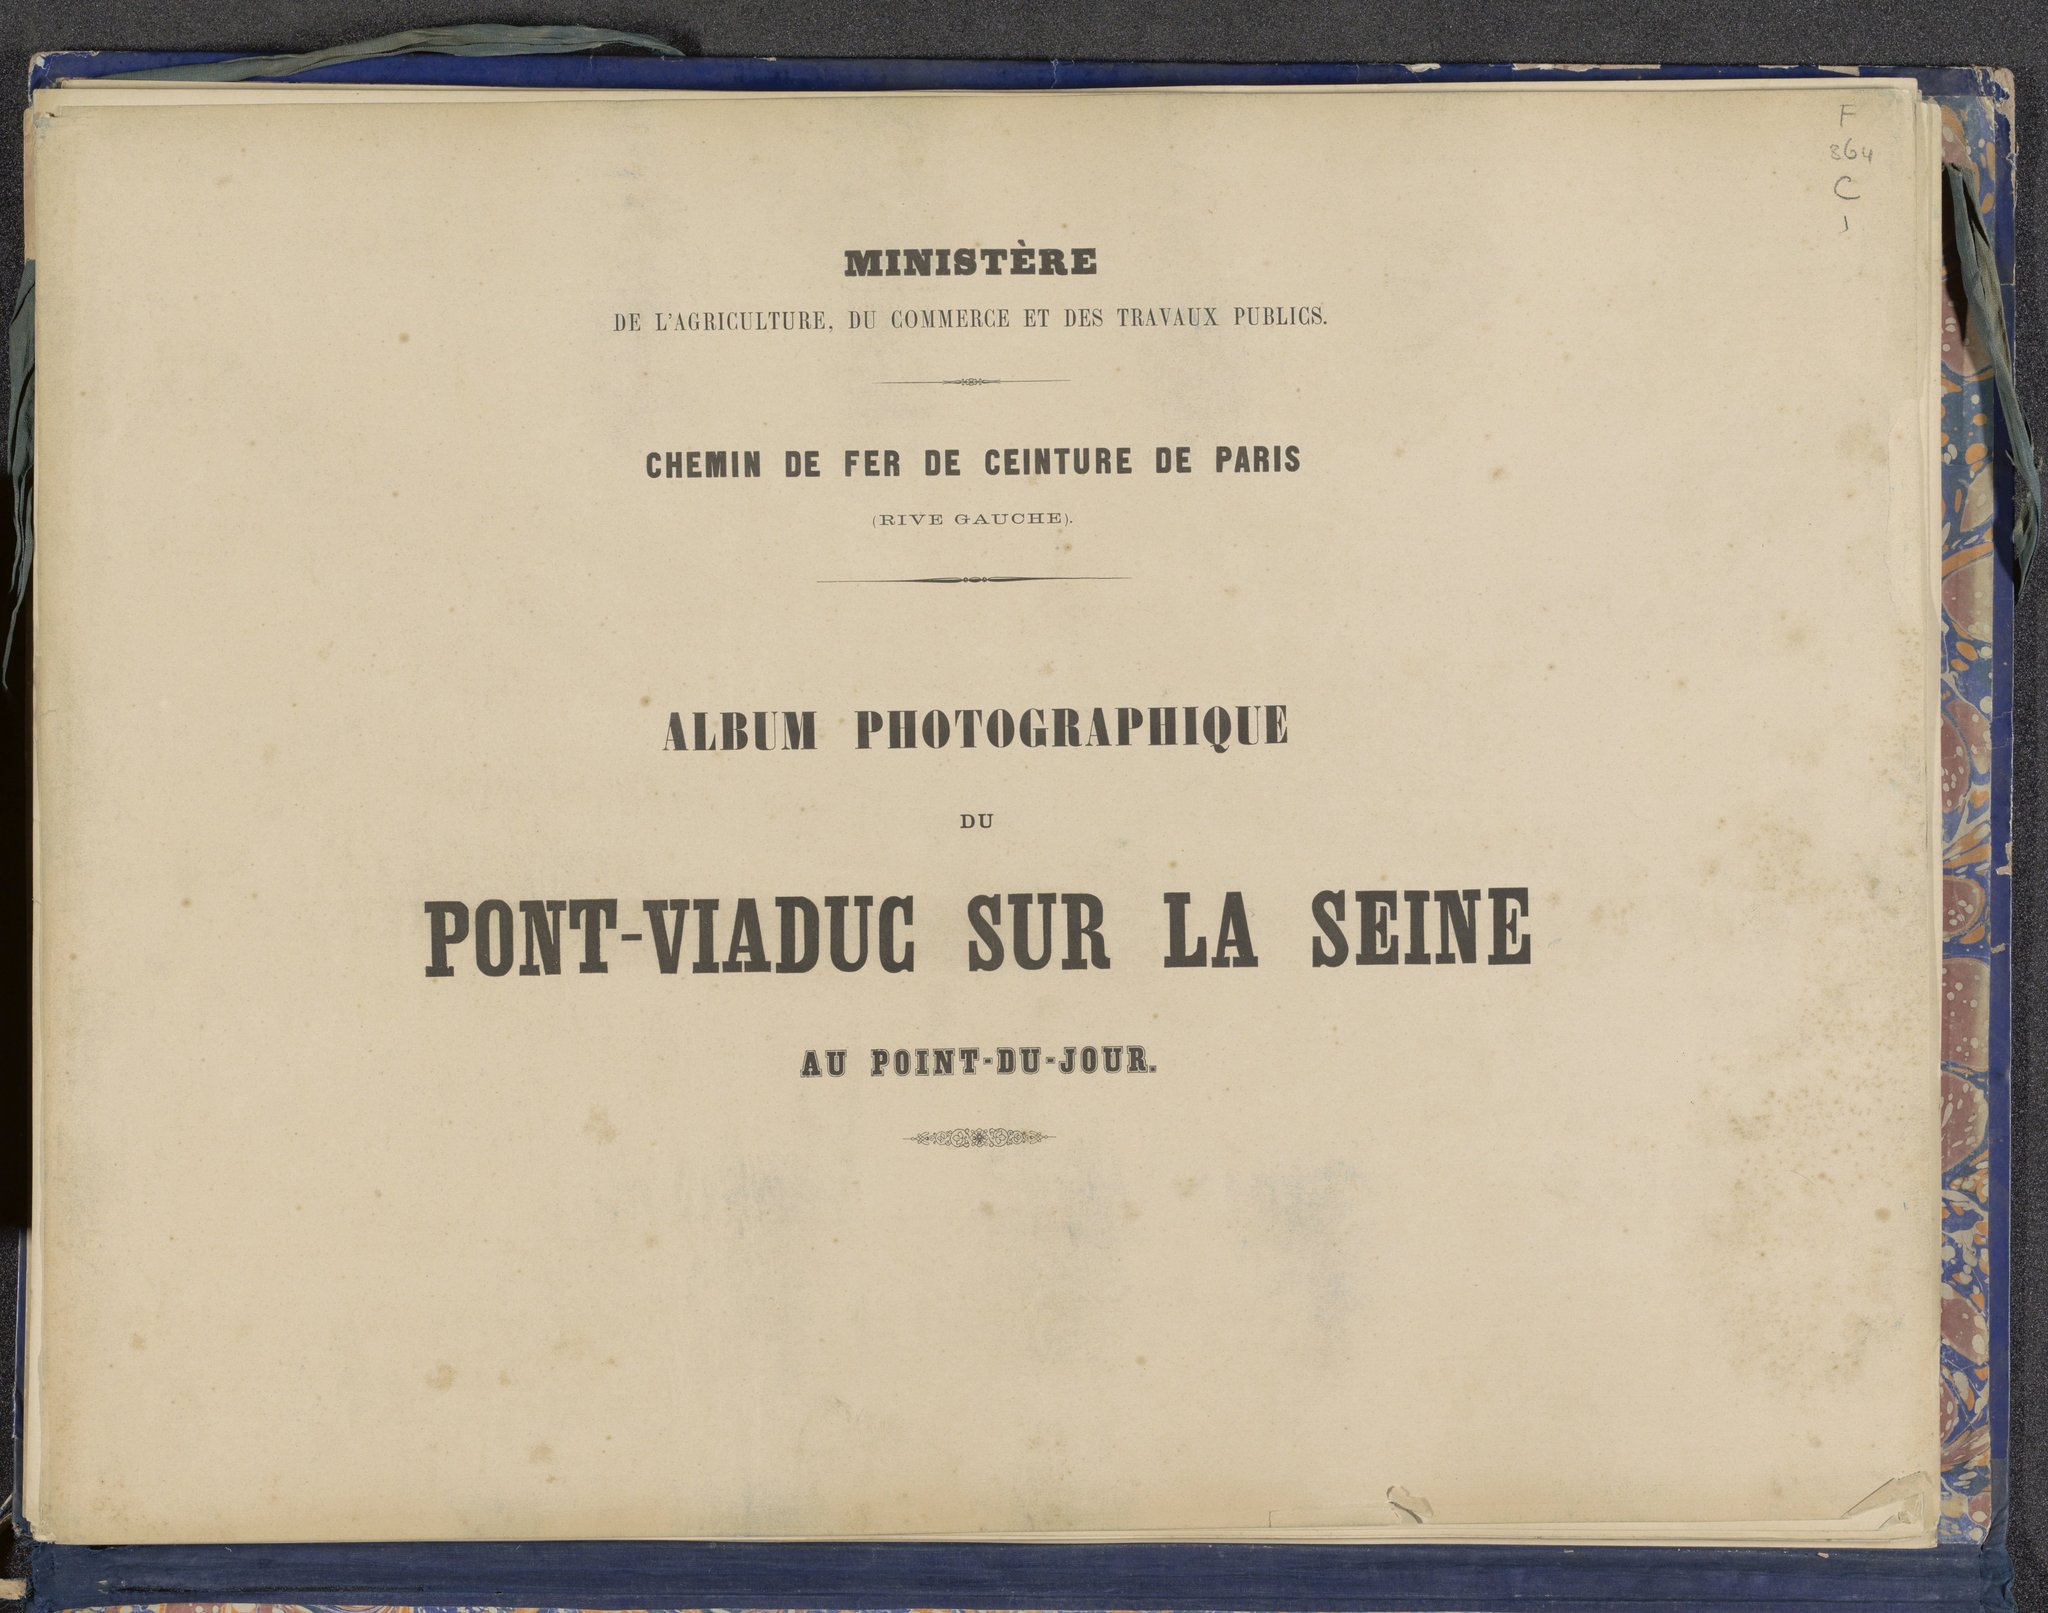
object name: portfolio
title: Album photographique du pont-viaduc sur la Seine au Point-du-Jour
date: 1868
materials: cardboard, linen, paper, photographic support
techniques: albumen print, lithograph, printing, marbled paper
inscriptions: name: ‘Papeterie D. Fortin Rue des Petits-Champs Paris’